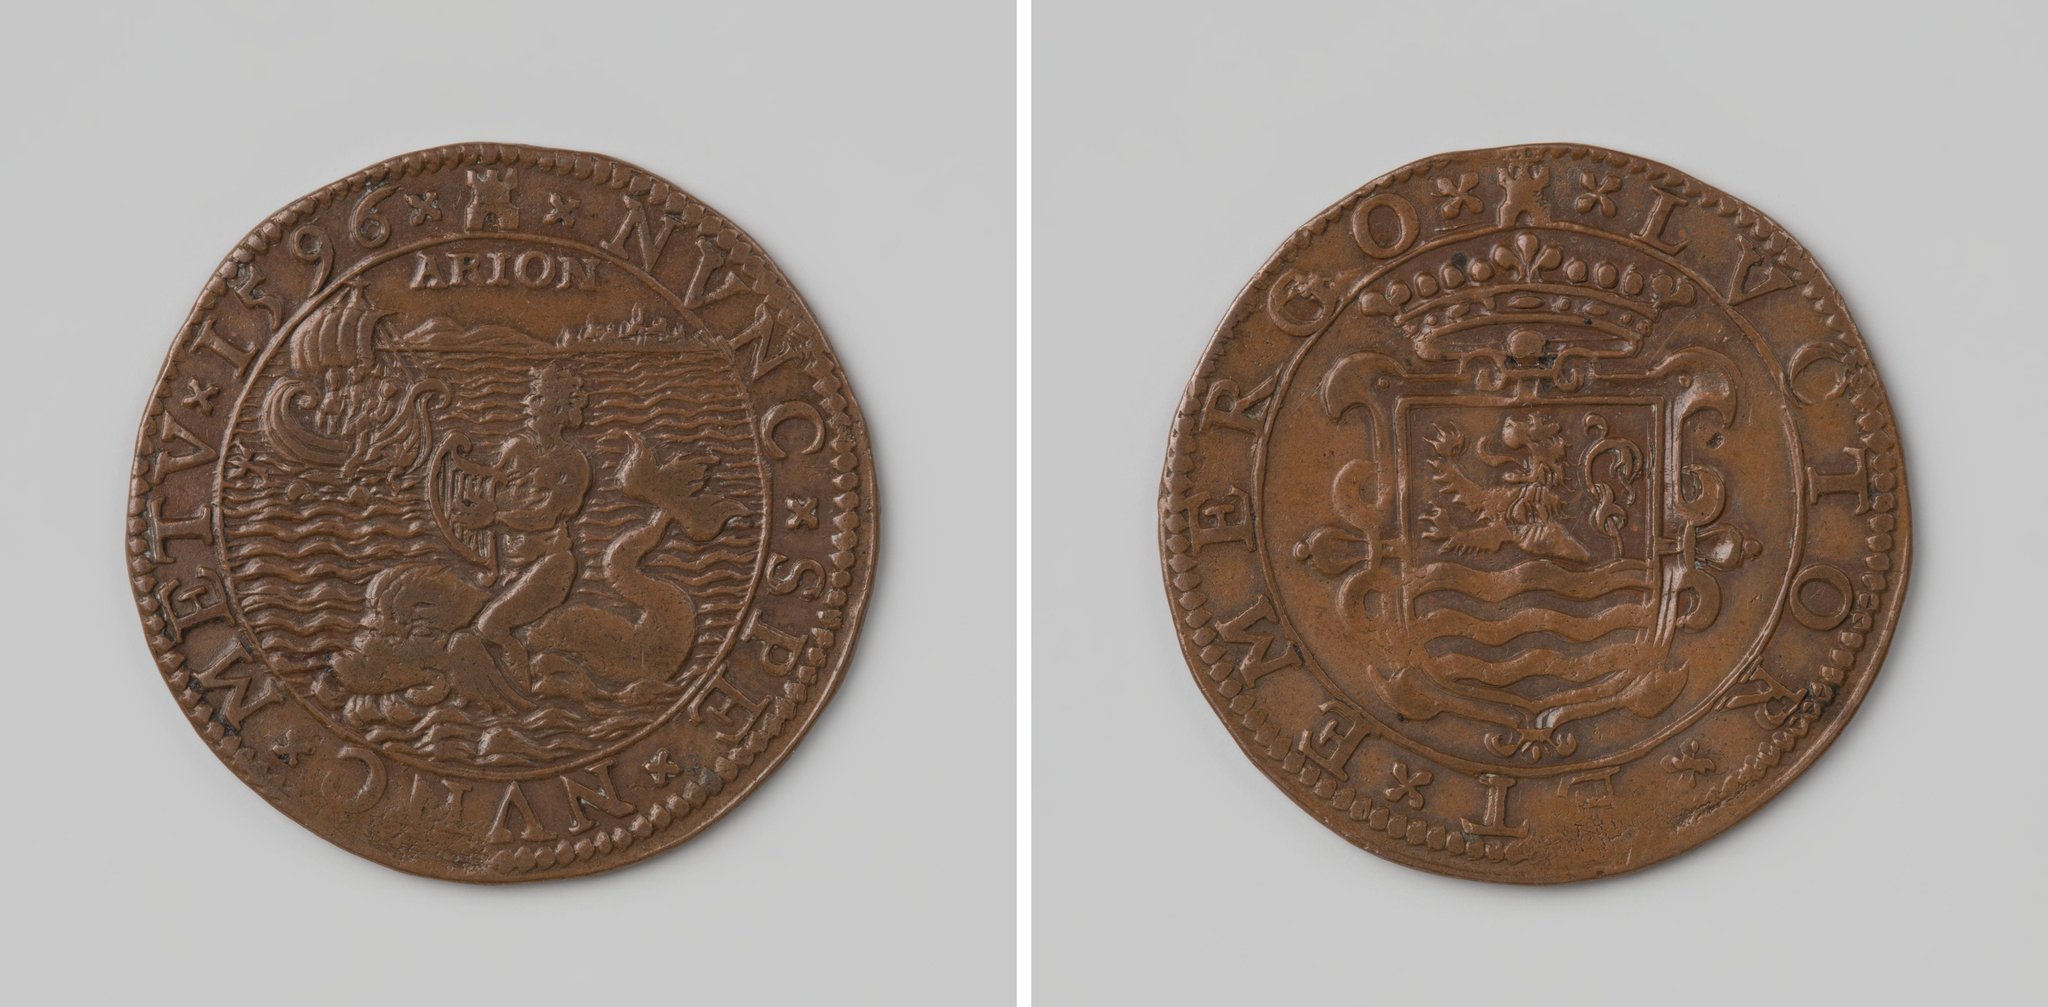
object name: jeton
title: Expansie van de zeevaart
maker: Anonymous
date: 1596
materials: copper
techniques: striking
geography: middelburg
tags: zeeland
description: Koperen penning. Voorzijde: Arion, spelend op luit, gezeten op rug van dolfijn; op achtergrond schip en kust onder opschrift binnen omschrift. Keerzijde: gekroond wapenschild in cartouche binnen omschrift.